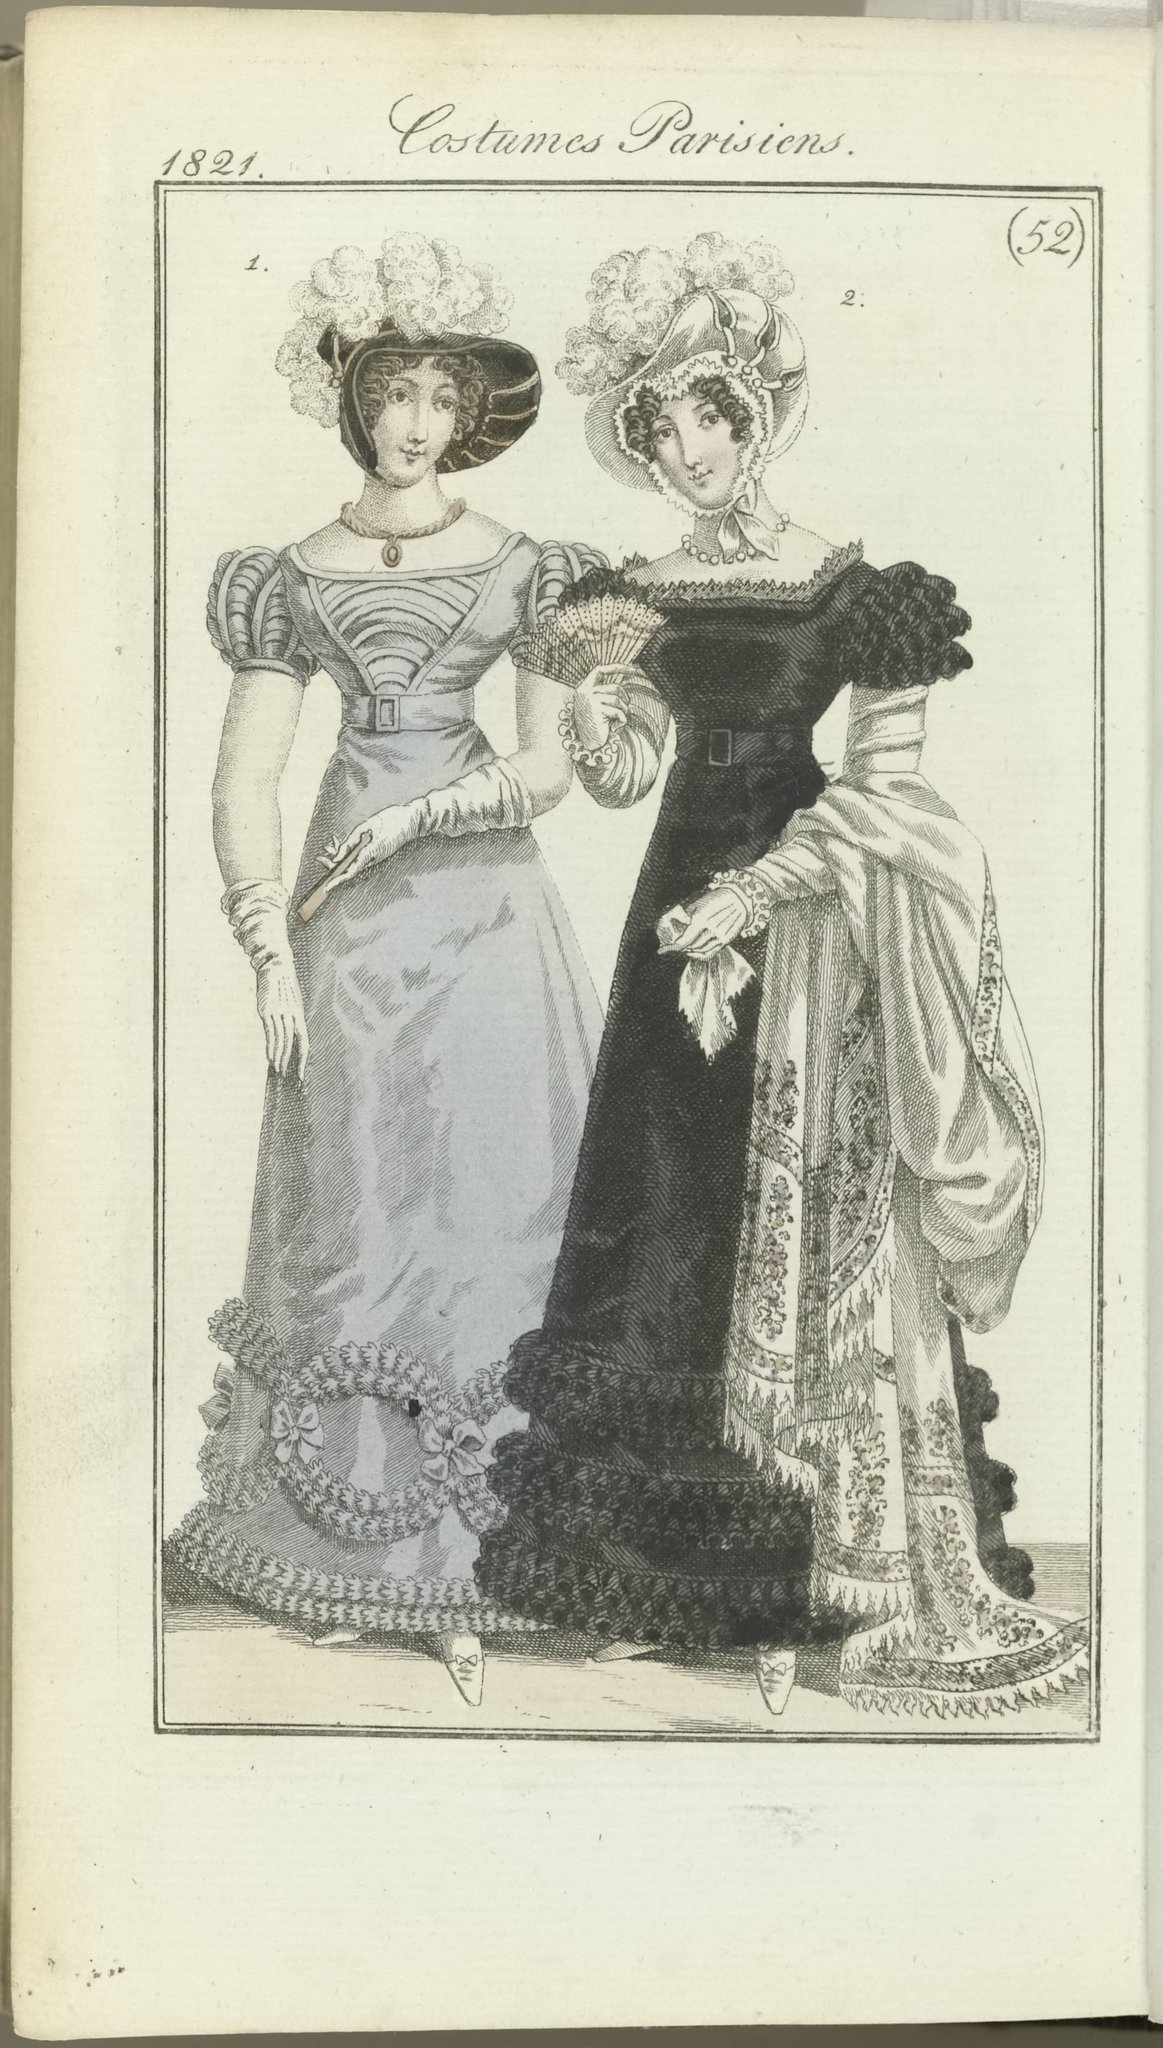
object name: fashion print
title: Journal des Dames et des Modes, editie Frankfurt 23 decembre 1821, Costumes Parisiens (52)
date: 1821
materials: paper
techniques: engraving, hand coloring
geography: frankfurt am main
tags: handkerchief (+ women's clothes), gloves, mittens (long gloves) (+ women's clothes), clothing for the upper part of the body (shawl) (+ women's clothes), head-gear: cap (+ women's clothes), fashion plates, head-gear: hat (+ women's clothes), dress, gown (+ women's clothes), necklace (+ women's clothes)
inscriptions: title: ‘Costumes Parisiens.’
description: De begeleidende tekst (p. 711) vermeldt: Fig. 1: Hoed van fluweel, versierd met gekrulde veren en goudbanden. Japon van gros d'automne, , het lijfje gegarneerd met 'rouleaux' en de onderrand met 'couronnes en ruches'. Witte handschoenen en witte schoenen. Fig. 2: Cornette van tule onder een hoed van satijn, versierd met gekrulde veren. Japon van fluweel, gegarneerd met stroken van gaze, met zoompjes van satijn. Mouwen van crêpe, versierd met 'rouleaux' van satijn Witte handschoenen. Witte schoenen. De prent maakt deel uit van het modetijdschrift Journal des Dames et des Modes, uitgegeven in Frankfurt als kopie van de Franse editie van Pierre de la Mésangère, Parijs, 1797-1839.